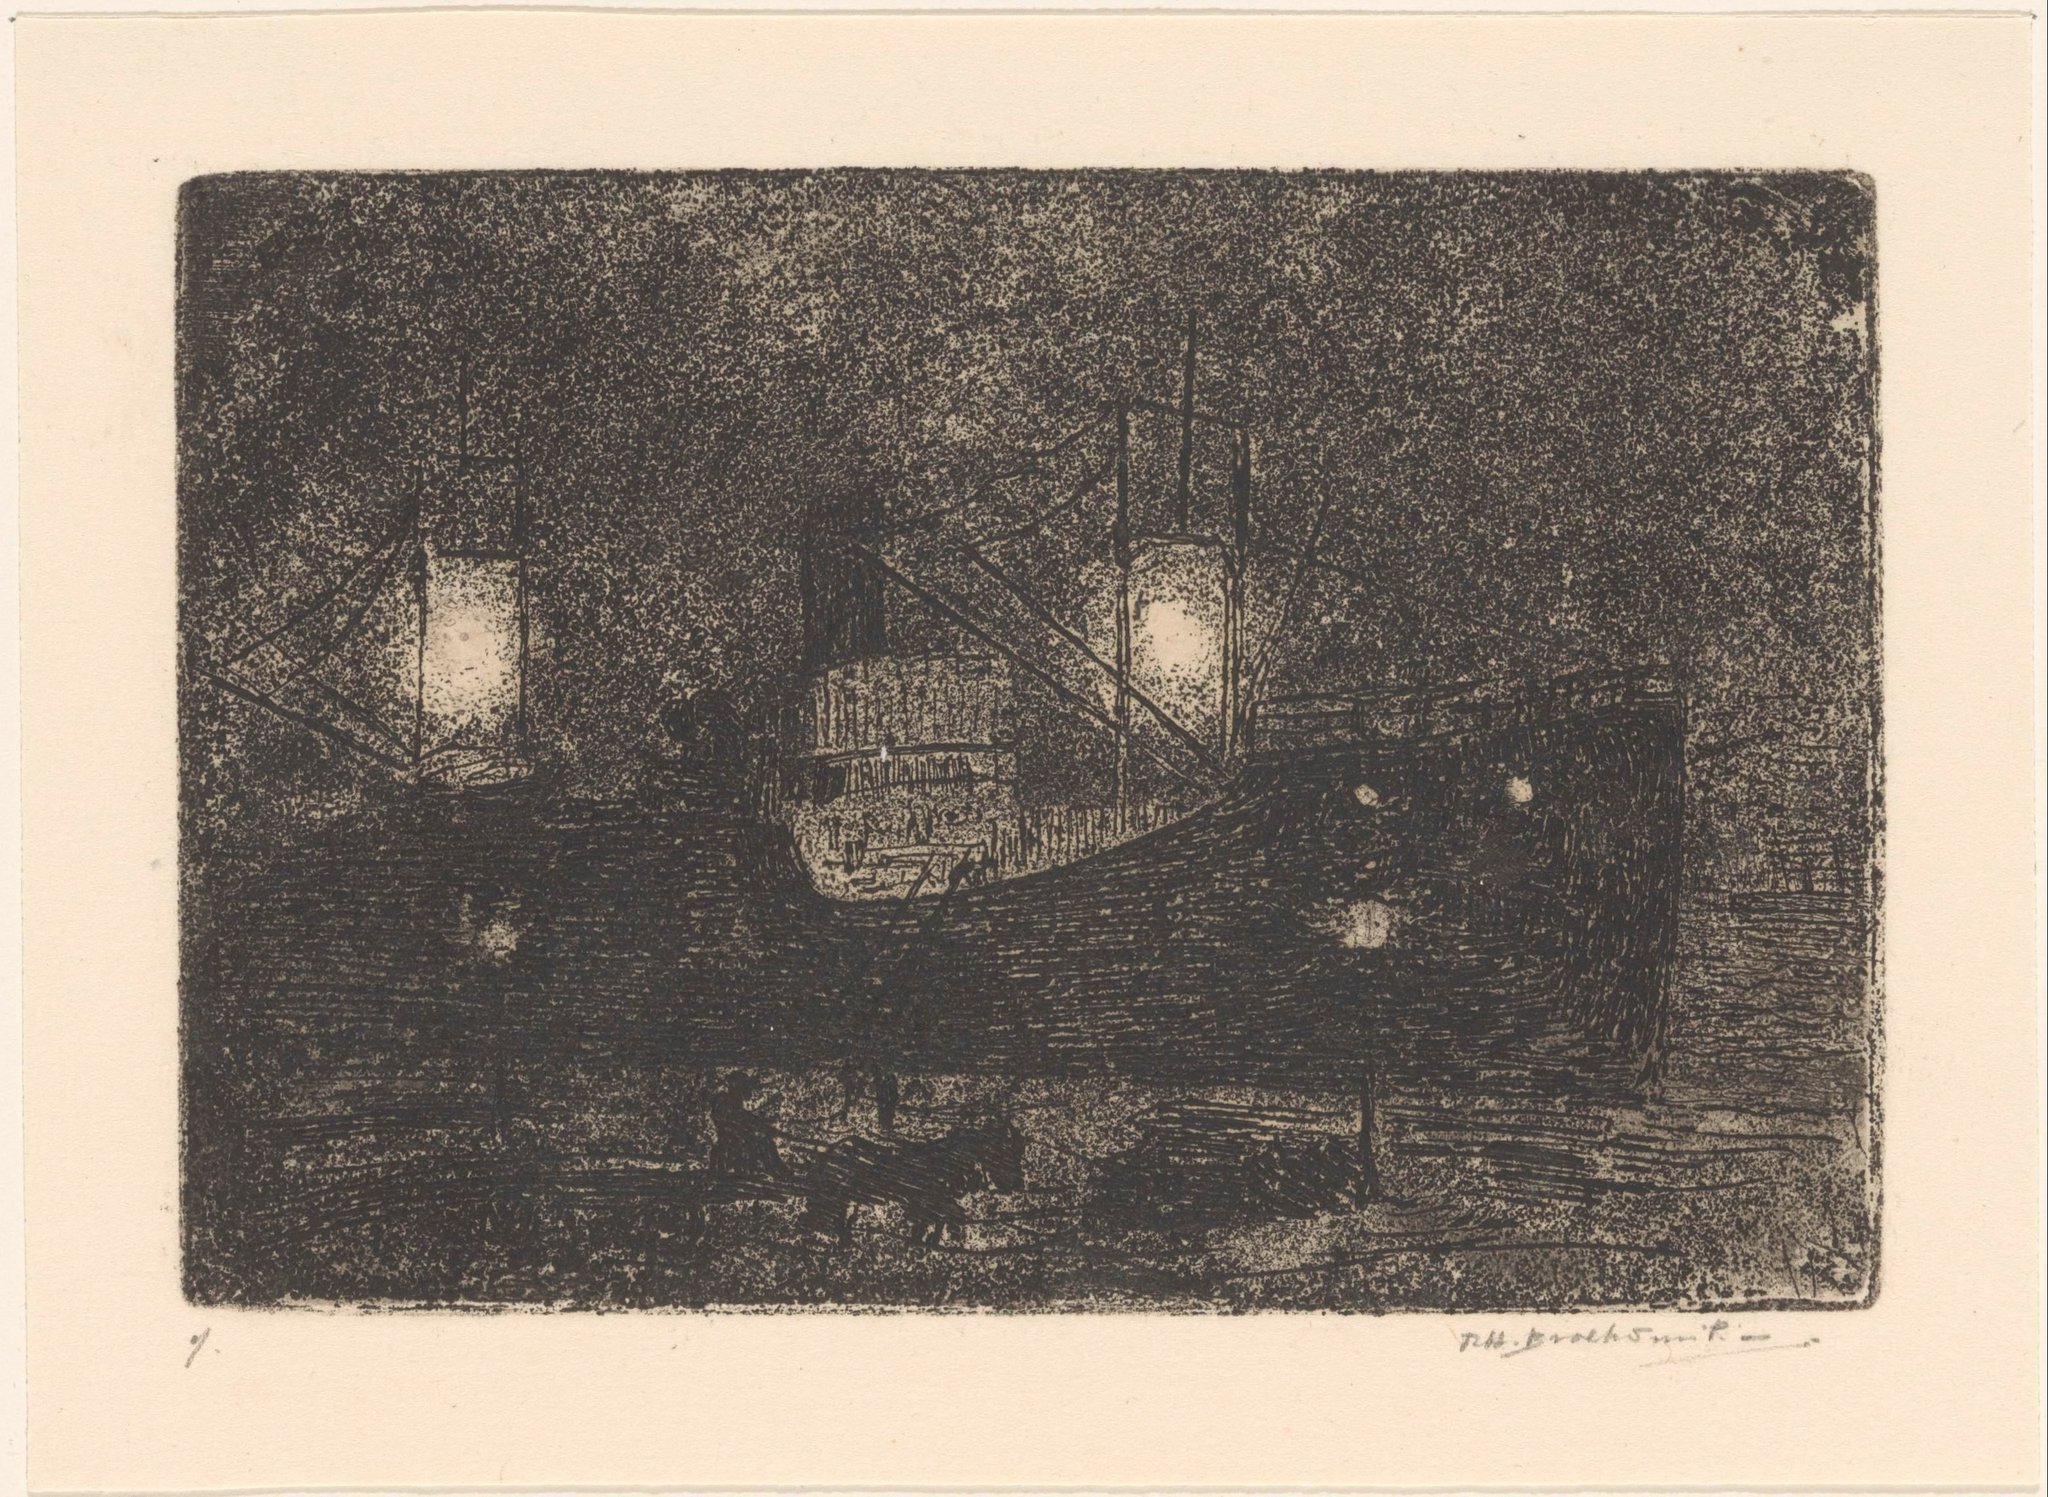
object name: print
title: Boot aan kade bij avond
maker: frederika henriëtte broeksmit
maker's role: draughtsman, print maker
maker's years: 1875-1945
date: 1885-1931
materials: paper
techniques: aquatint, etching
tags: evening, pier, quay, wharf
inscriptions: collector's mark: Lugt 2228